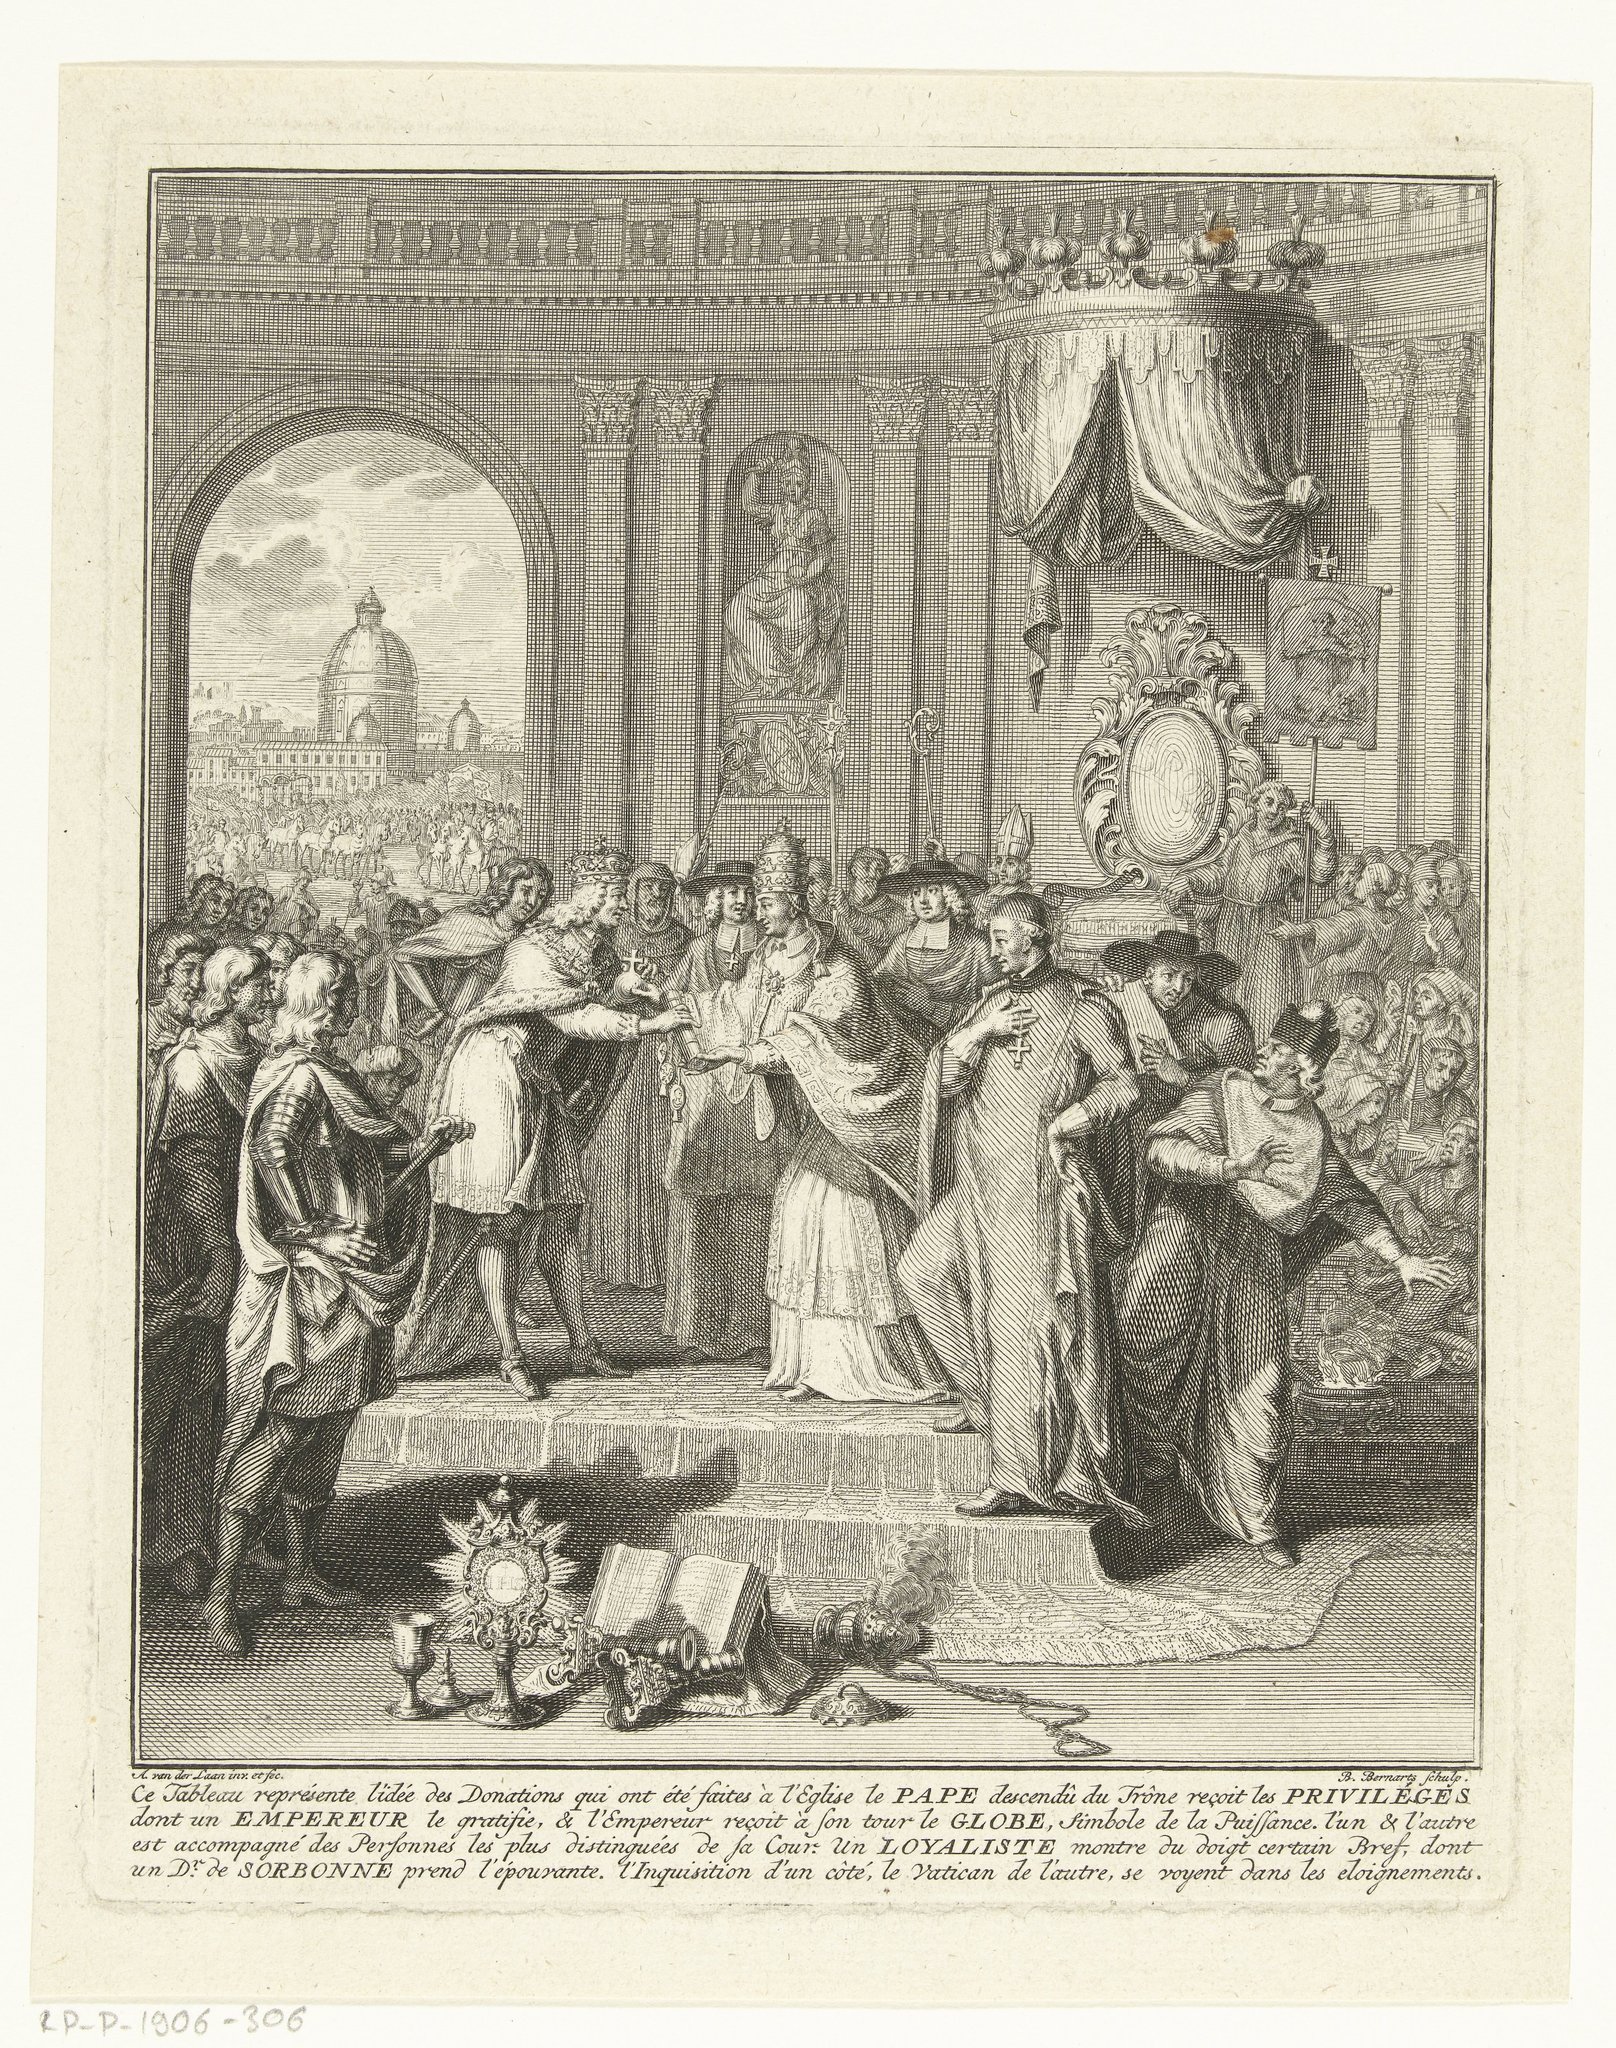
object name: print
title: De paus en de keizer wisselen privileges uit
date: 1711-1737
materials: paper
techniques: engraving, etching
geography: amsterdam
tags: emperor, pope, rome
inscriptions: collector's mark: Lugt 2228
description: In een paleis zijn paus en keizer en hun hof verzameld. De keizer geeft de paus een rol met privileges, de paus geeft de keizer in ruil voor de privileges de rijksappel. Door het raam is het Sint-Pietersplein in Rome te zien. Met een uitleg van de scène in het Frans.